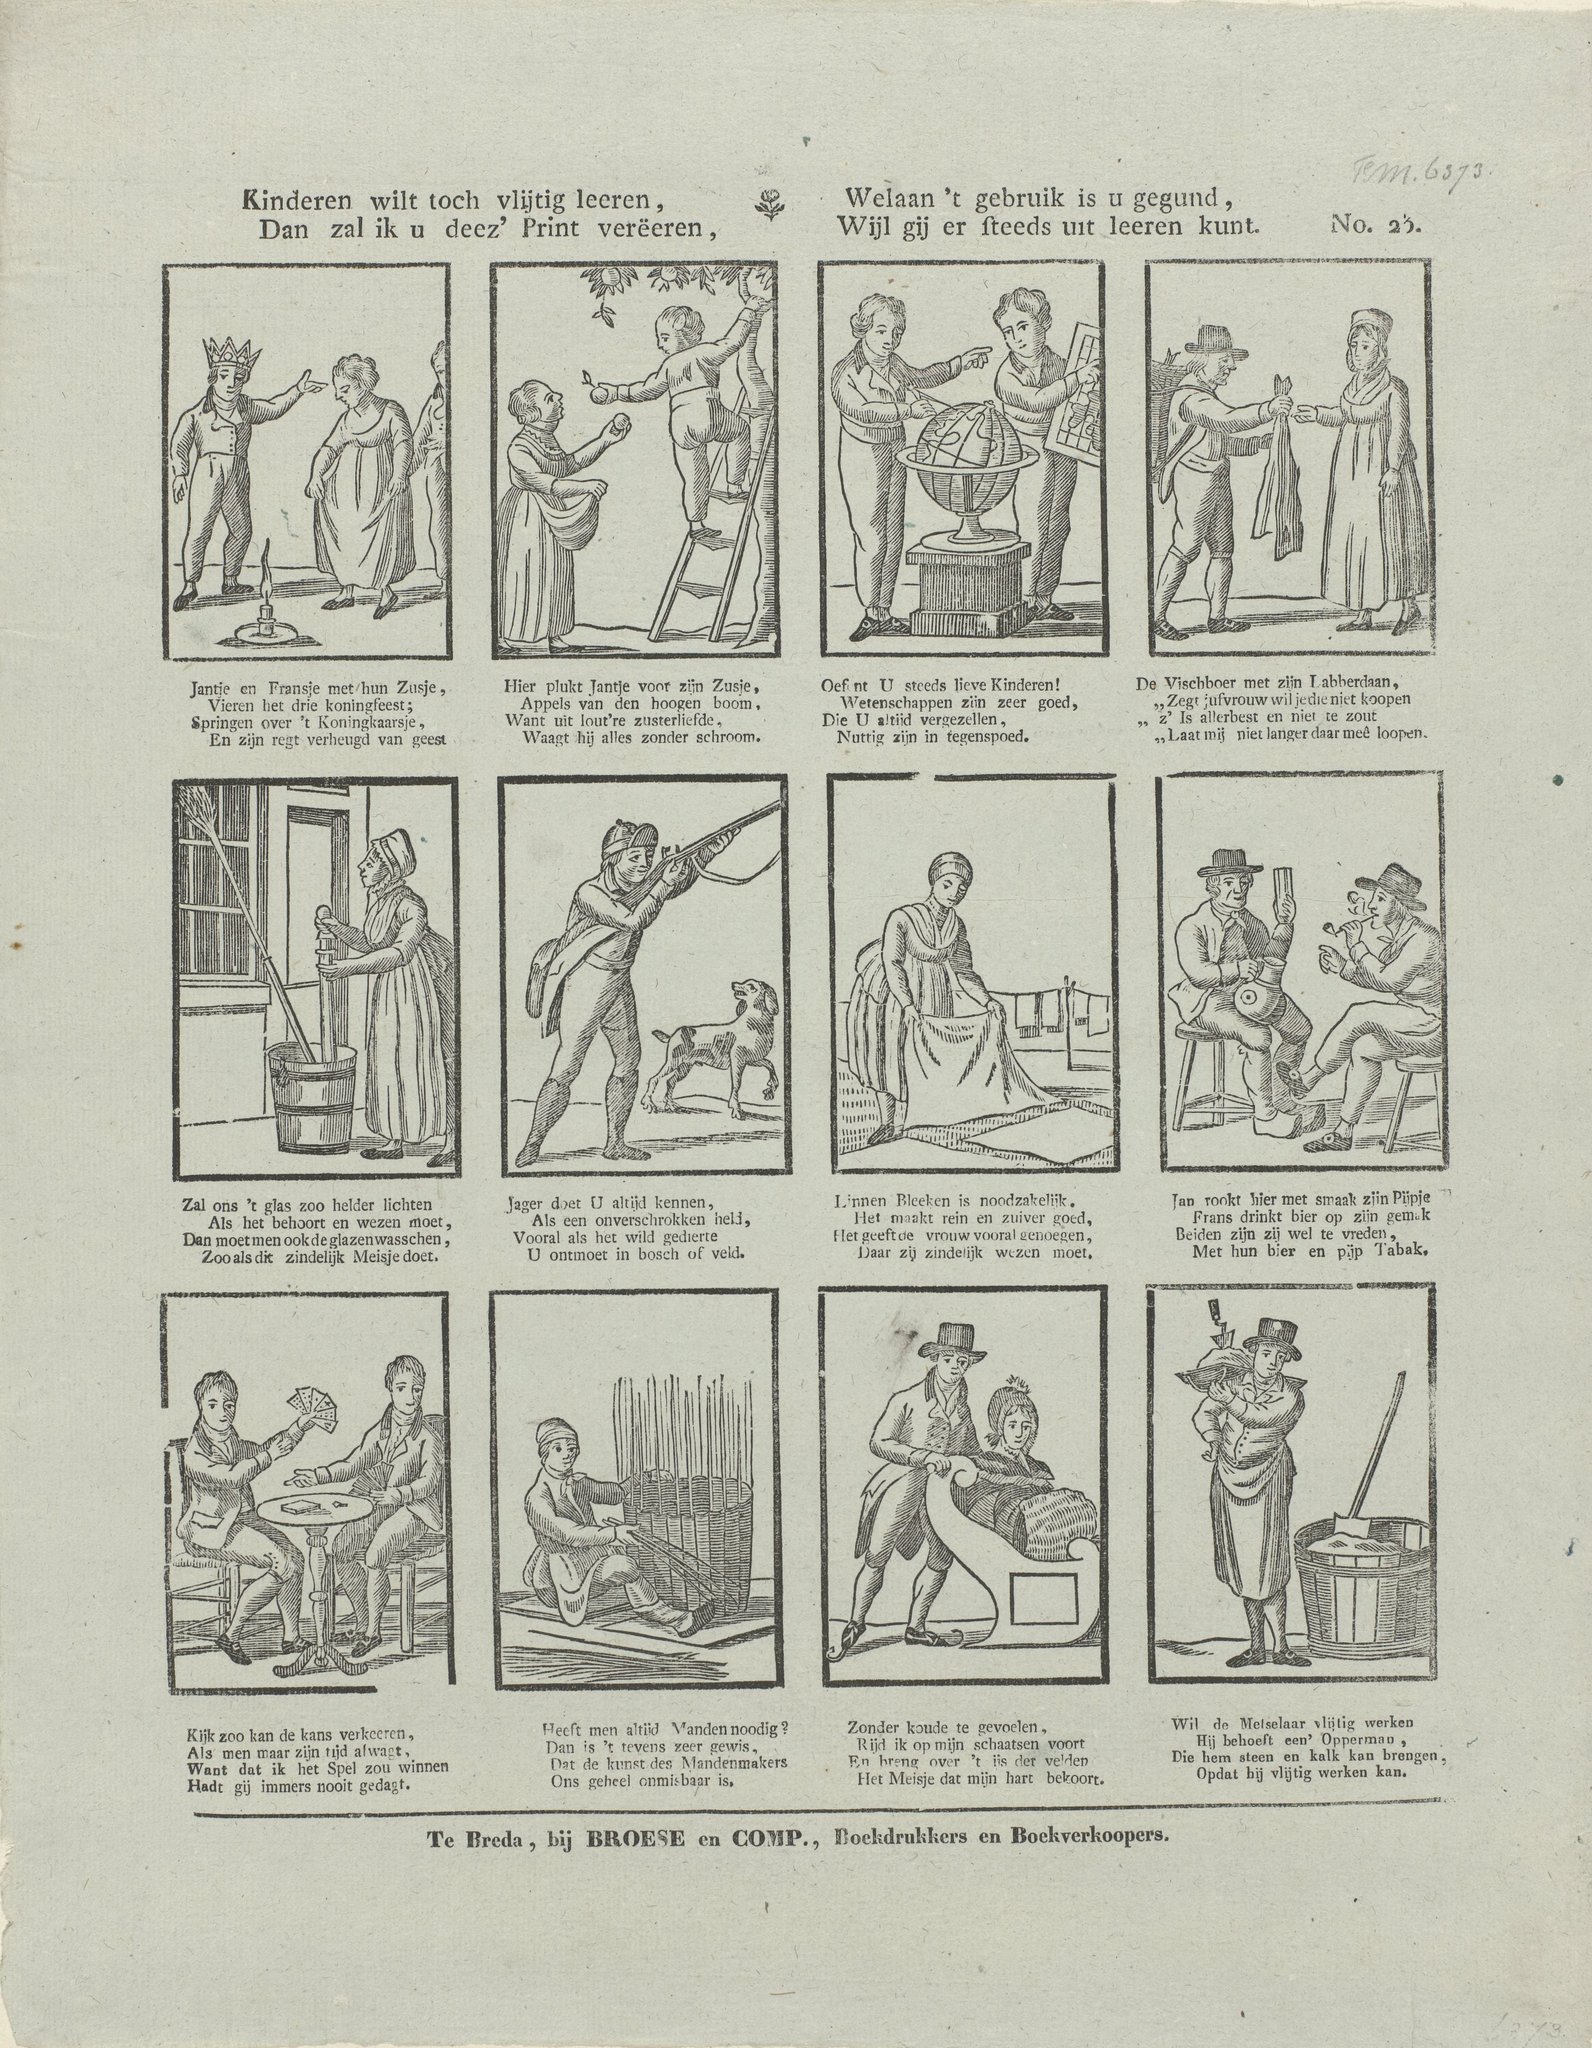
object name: print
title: Kinderen wilt toch vlijtig leeren, / Dan zal ik u deez' print verëeren, / Weläan 't gebruik is u gegund, / Wijl gij er steeds uit leeren kunt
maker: Anonymous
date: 1828-1853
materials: paper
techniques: letterpress printing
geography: breda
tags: recreation, amusement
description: Blad met 12 voorstellingen van verschillende bezigheden, zoals mandenvlechten, roken en kaarten. Onder elke afbeelding een vierregelig vers. Genummerd rechtsboven No. 23.